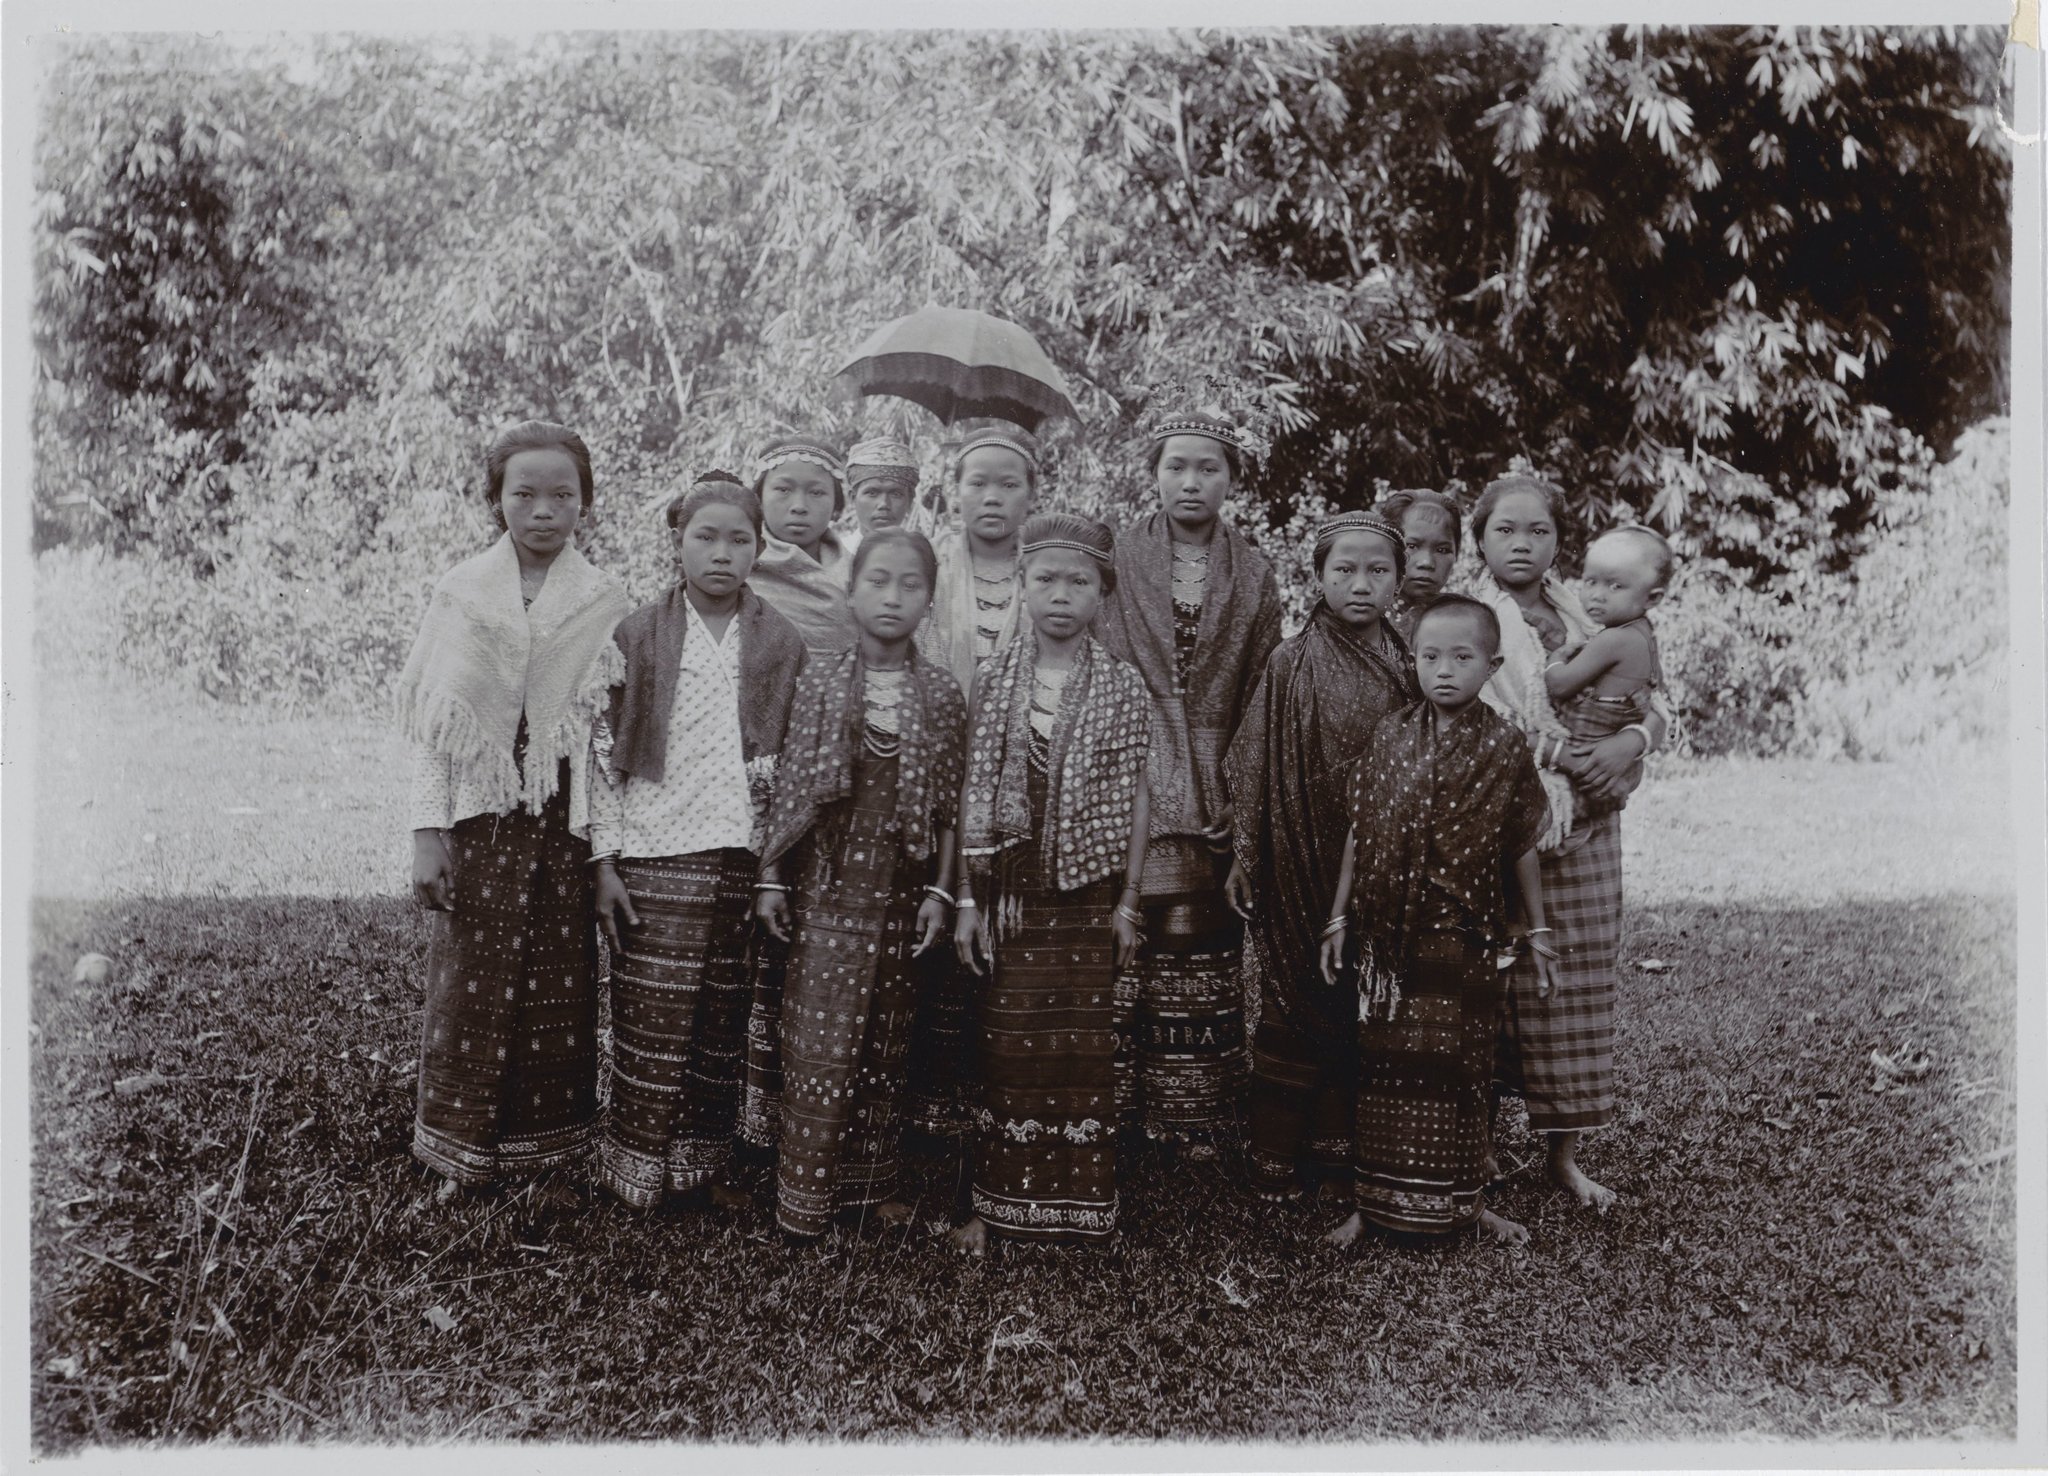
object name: photograph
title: Een groep jonge vrouwen in sarong en met schouderdoeken in Lampong op Sumatra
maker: johanna hermina marmelstein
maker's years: 1897-1990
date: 1900-1915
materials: paper, photographic support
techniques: albumen print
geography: jakarta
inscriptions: title: ‘Lampongsche ... (?)’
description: Een groep jonge vrouwen in sarong en met schouderdoeken in Lampong op Sumatra. Een aantal van de vrouwen draagt ook iets op het hoofd.